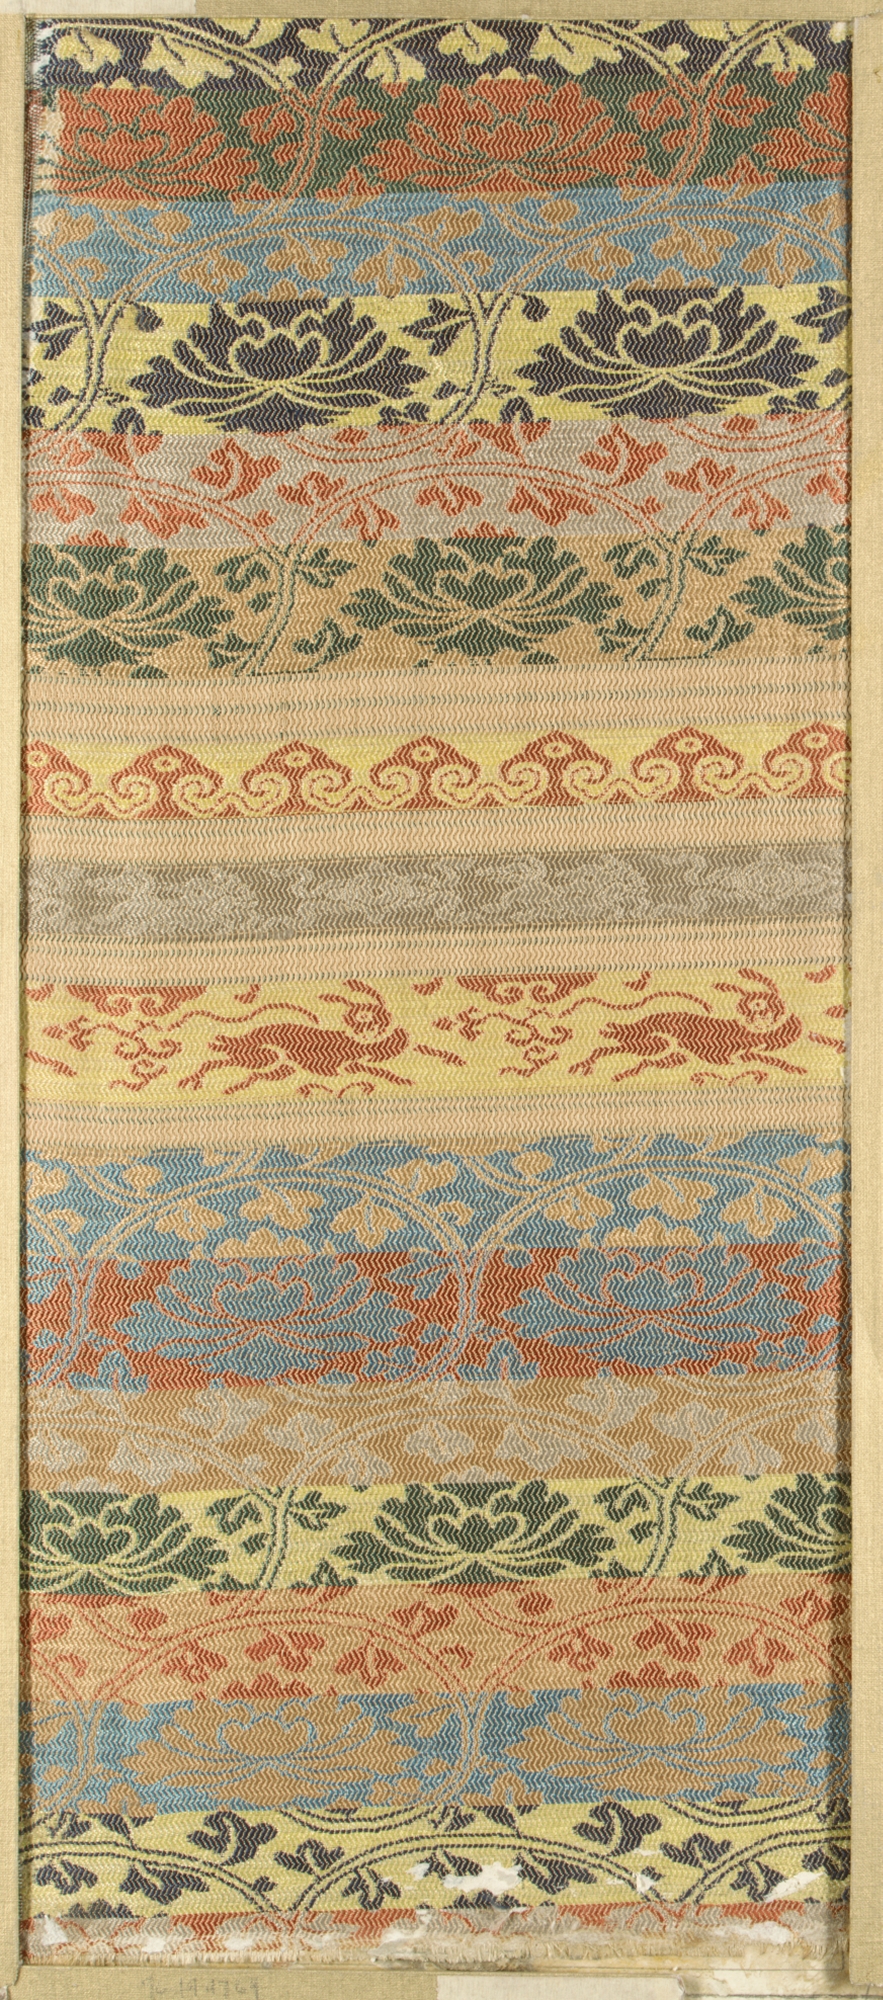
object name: piece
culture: japanese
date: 1801-1833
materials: silk